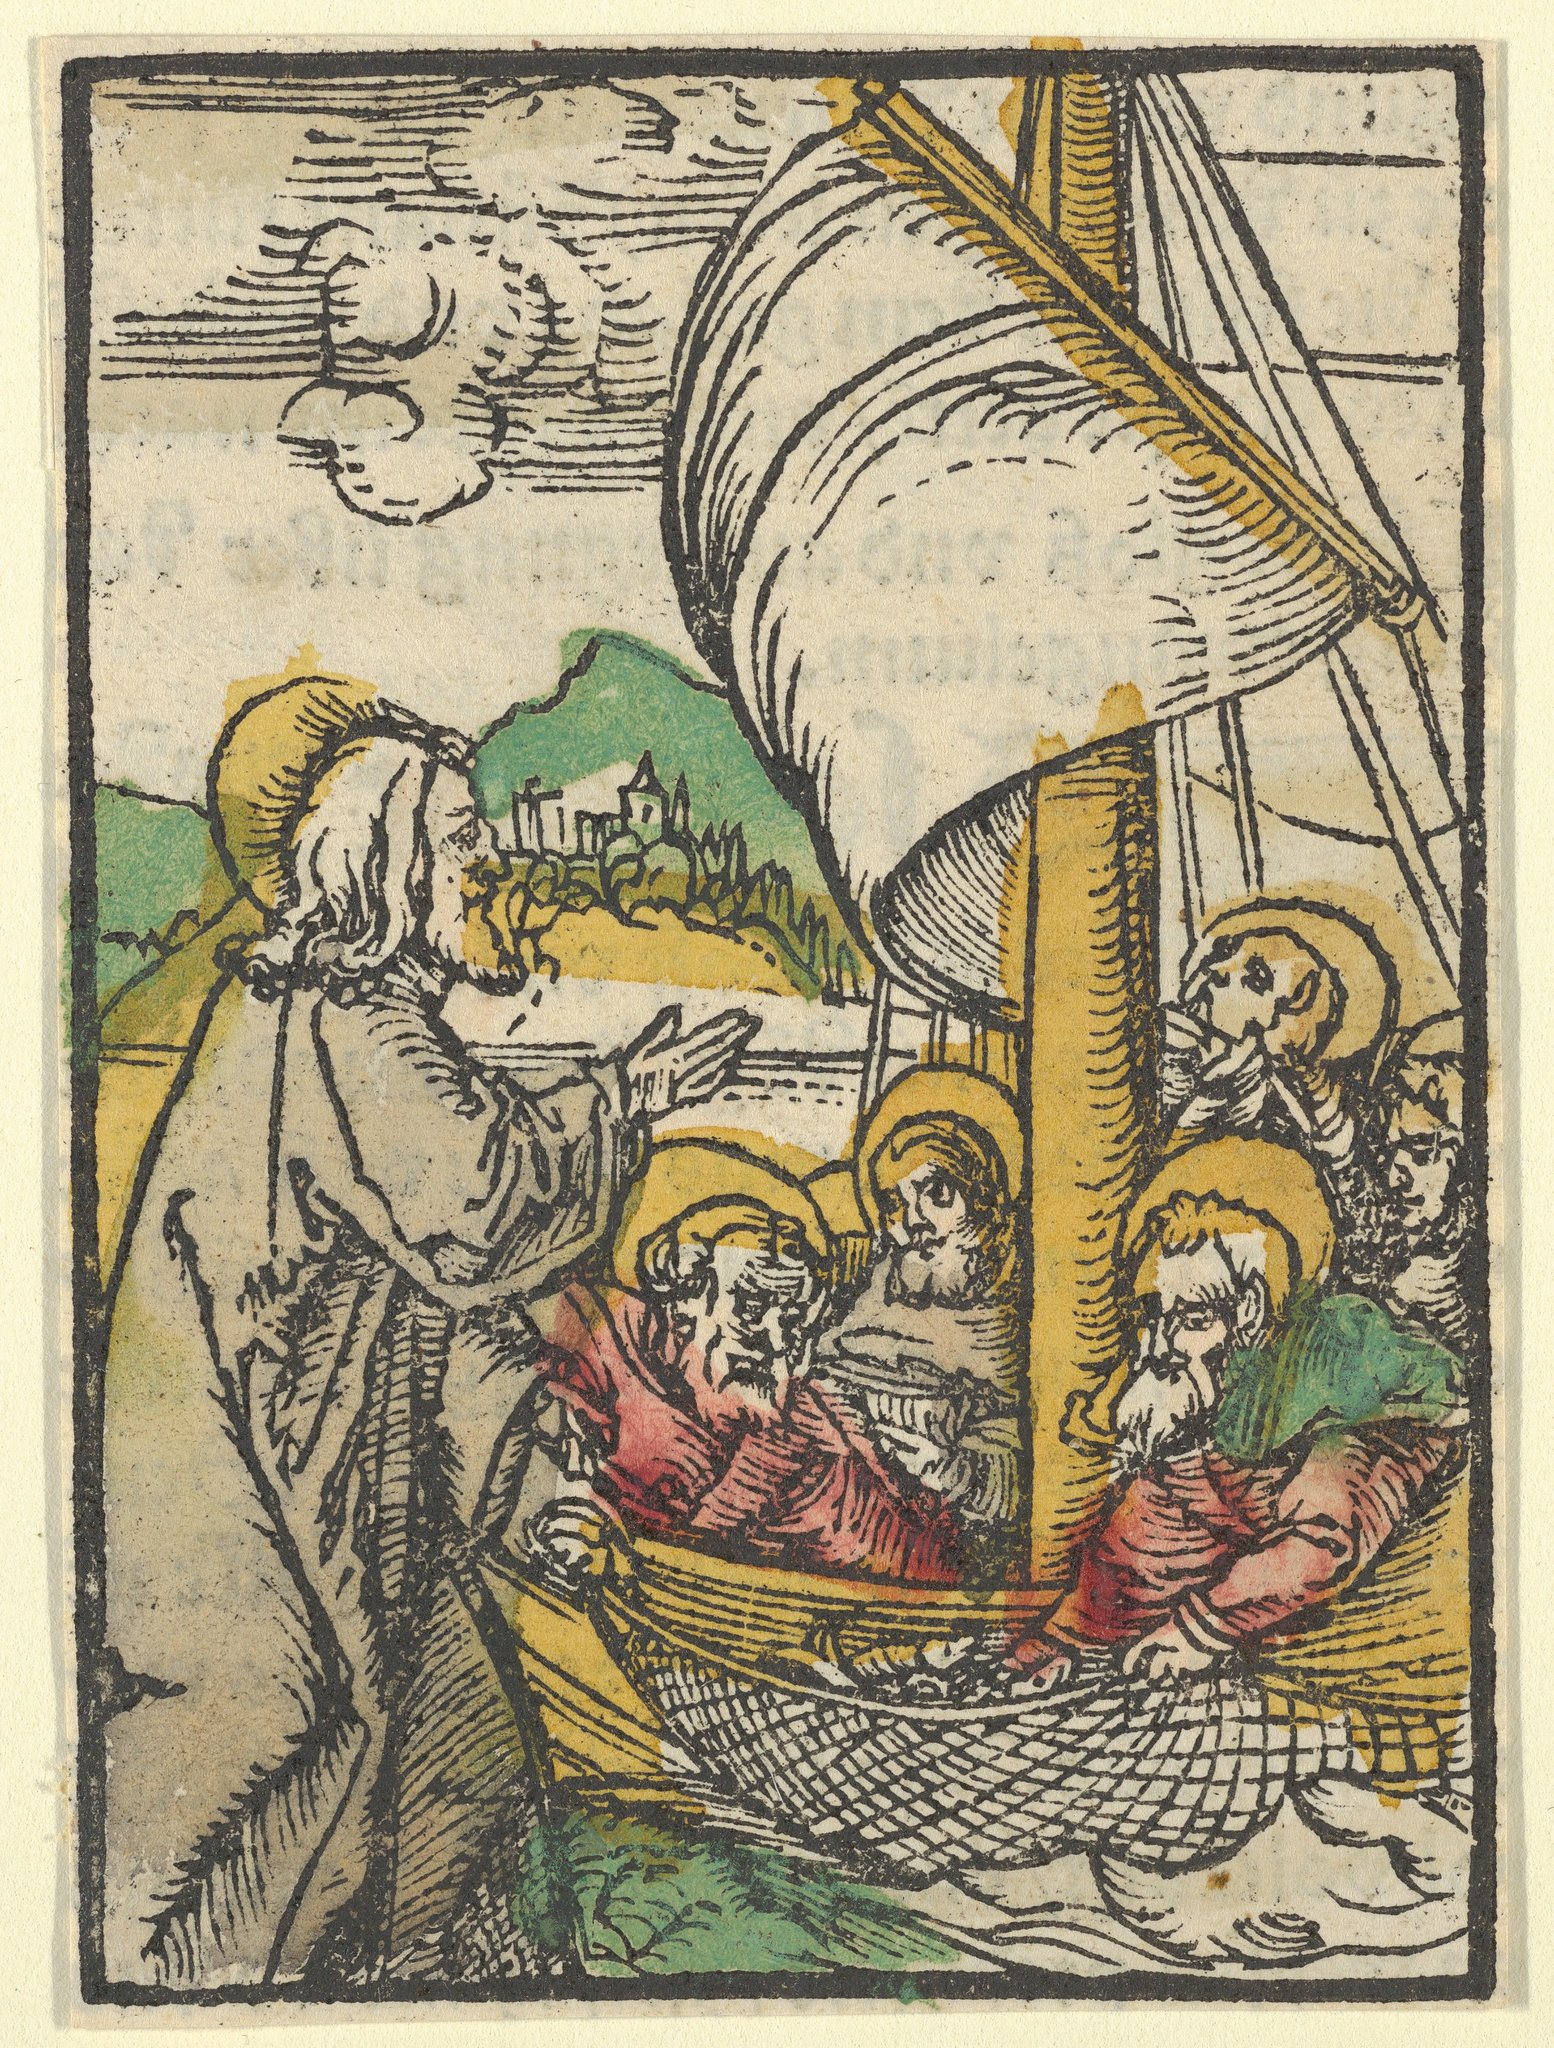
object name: print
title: The Second Draught of Fishes by Saint Peter, from Das Plenarium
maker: hans schäufelein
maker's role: artist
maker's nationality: german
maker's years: 1480-1540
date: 1517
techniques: hand coloring, woodcut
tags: men,saint peter